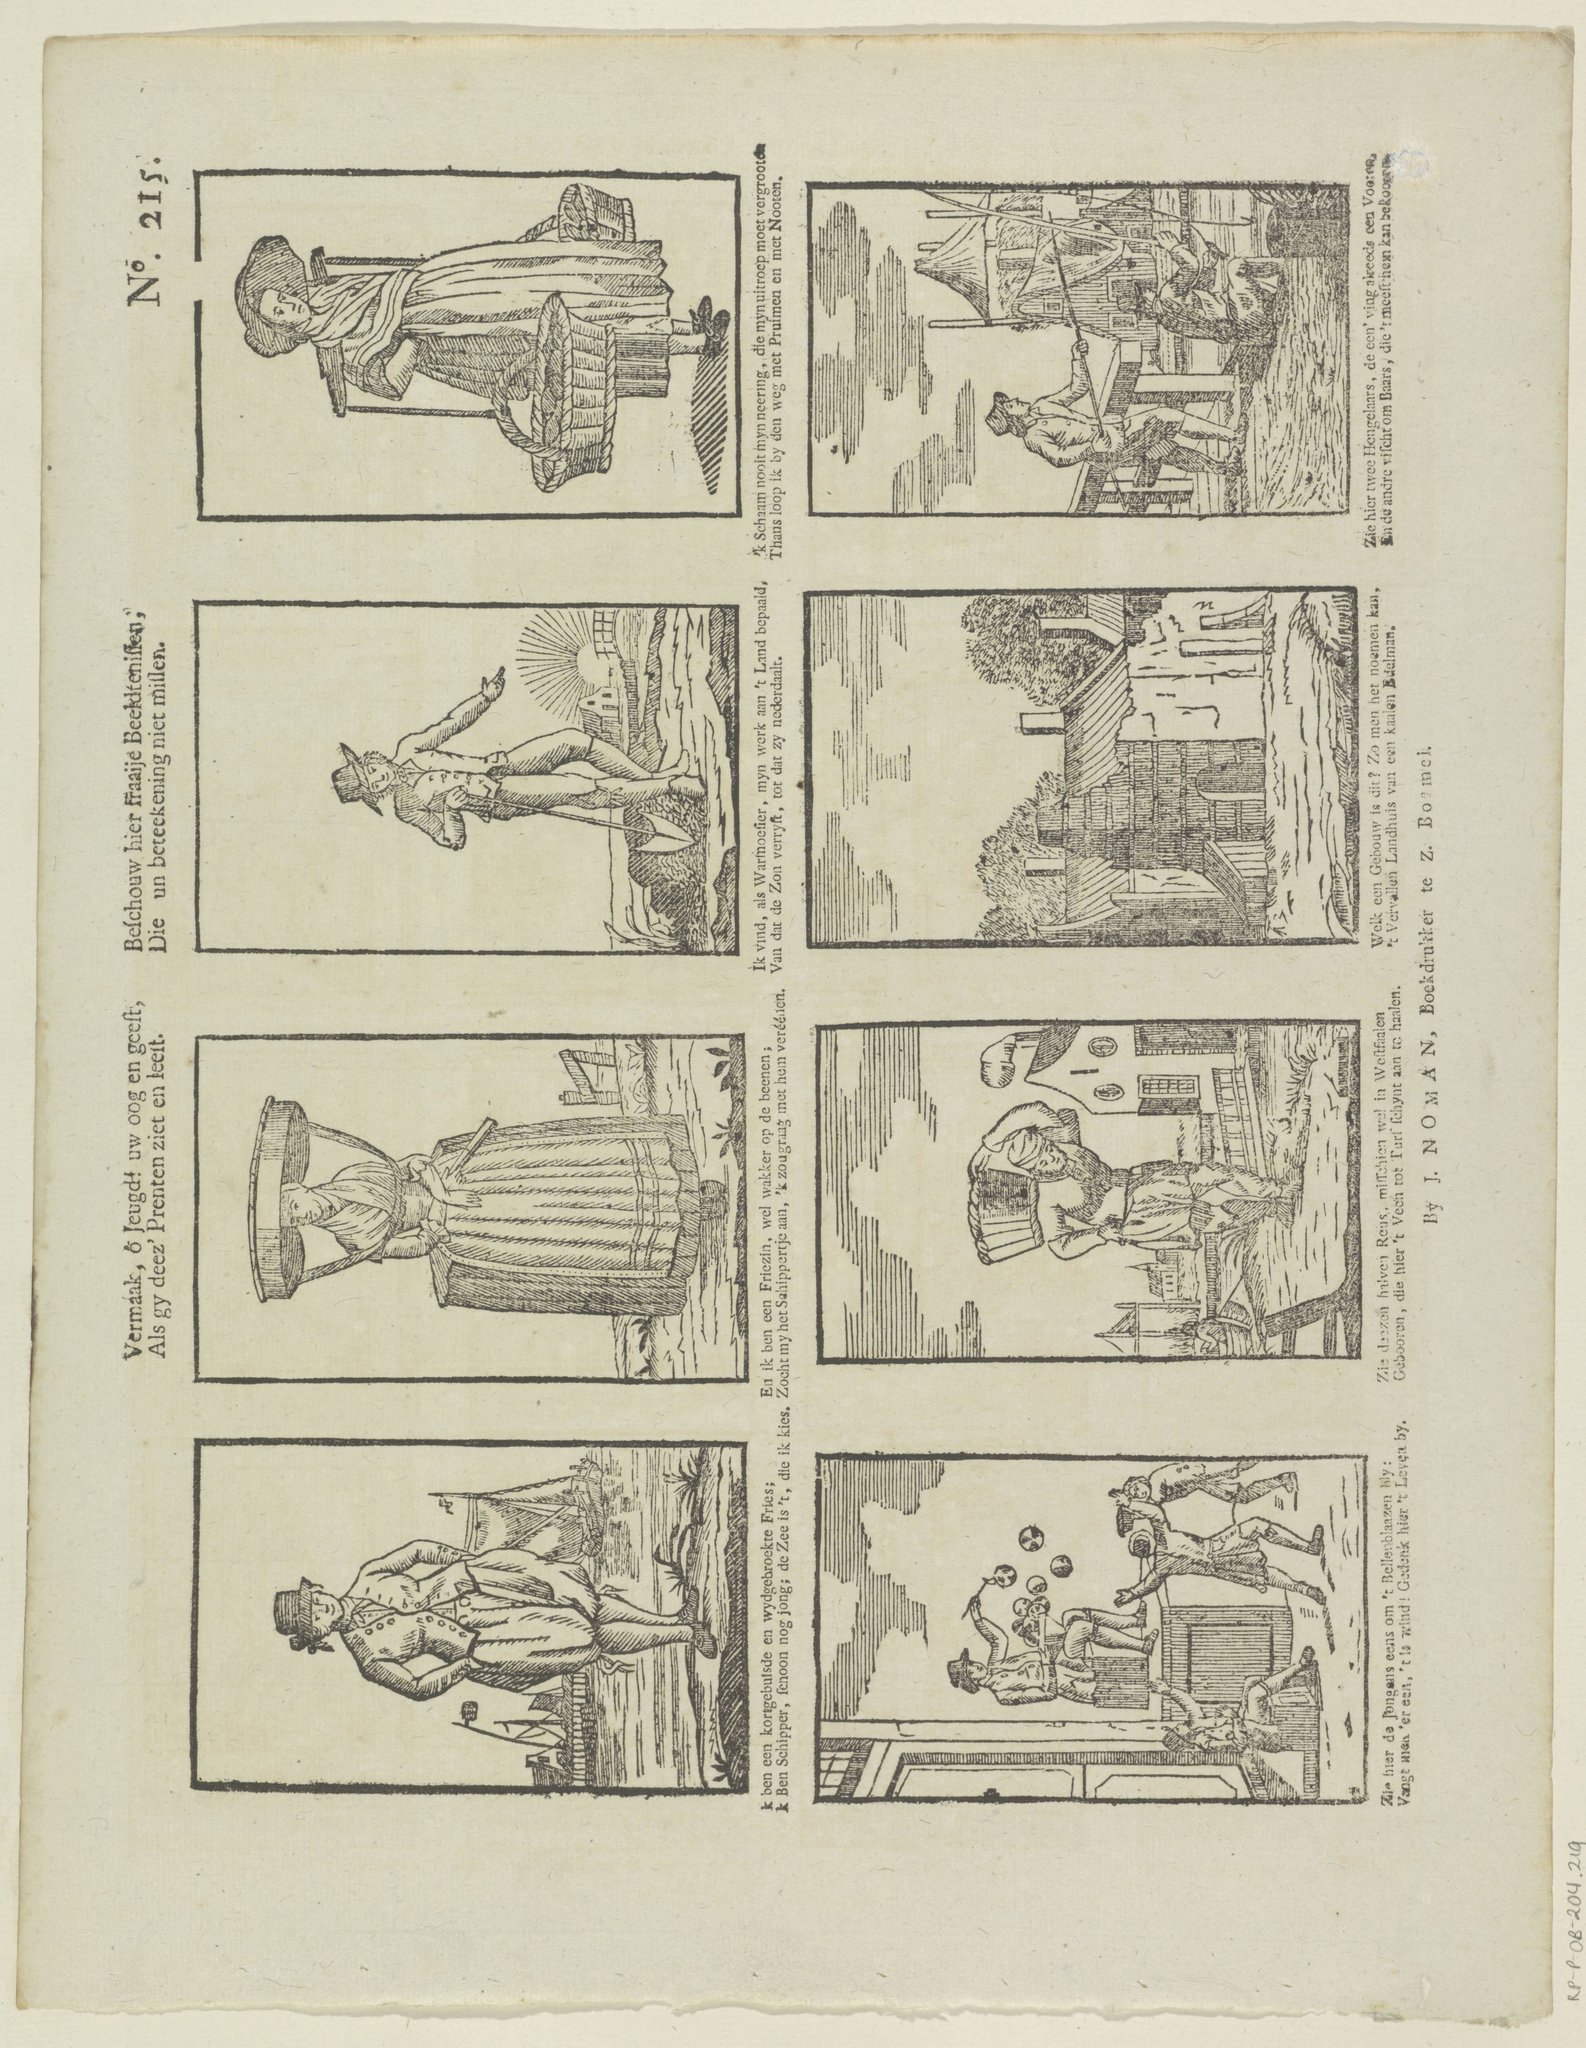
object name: print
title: Vermaak, ô jeugd! uw oog en geeft, / Als gy deez' prenten ziet en leest. / Beschouw hier fraaije beeldtenissen, / Die un beteekening niet missen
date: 1806-1830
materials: paper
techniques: letterpress printing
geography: zaltbommel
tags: human types, farmers, street-trader, fisherman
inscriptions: collector's mark: Lugt 2760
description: Blad met 8 voorstellingen van verschillende figuren en beroepen. Onder elke voorstelling een tweeregelig vers. Genummerd rechtsboven: No. 215.